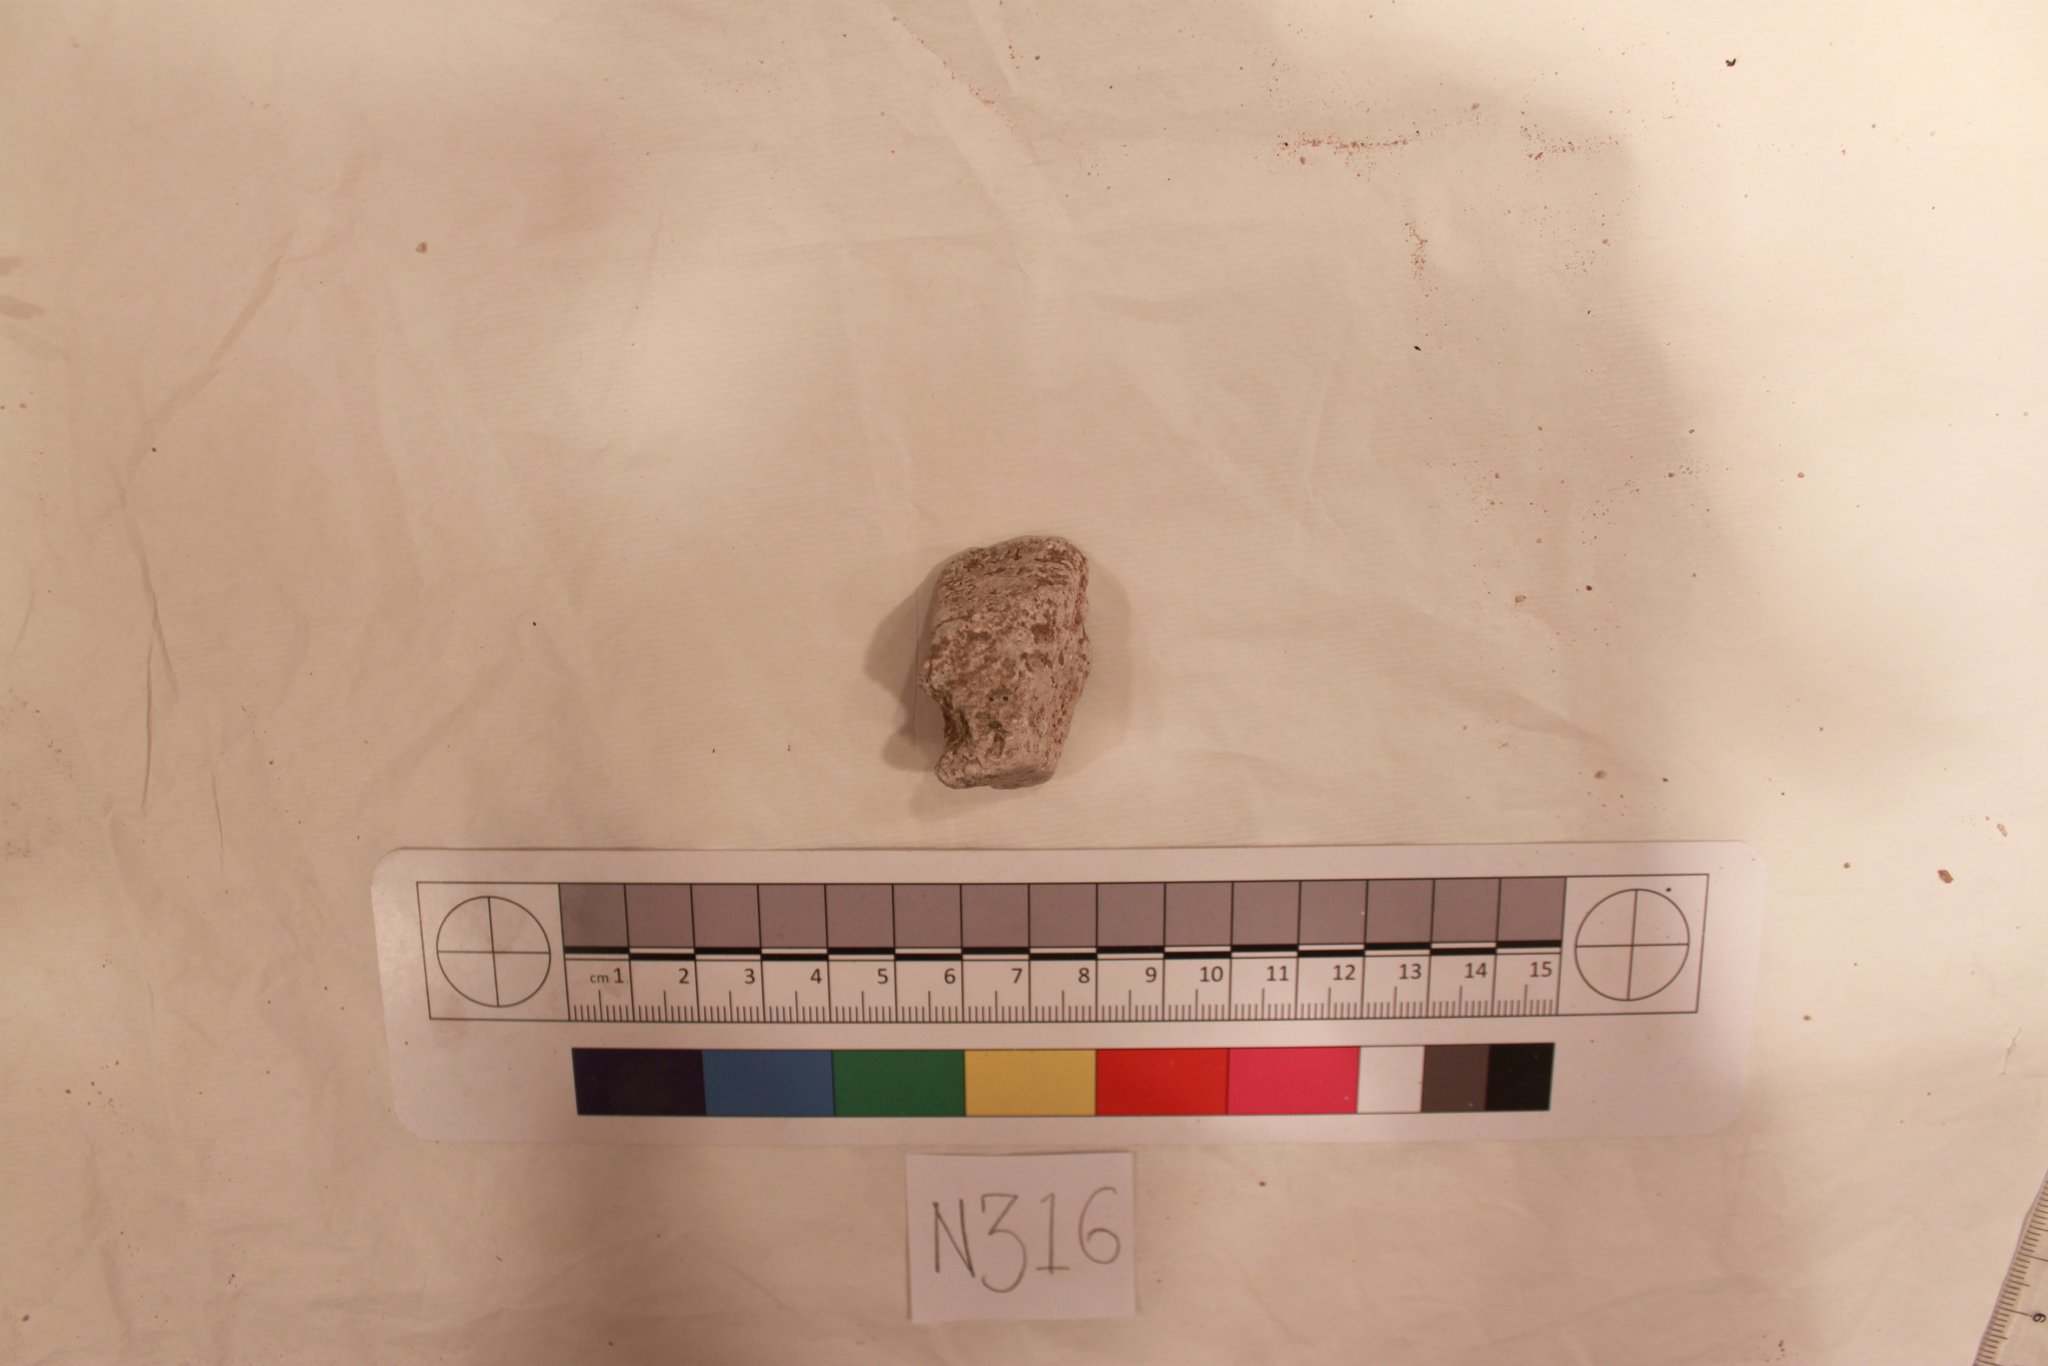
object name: fragment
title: Stucco Fragment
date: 701-1200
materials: plaster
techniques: carving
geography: iran